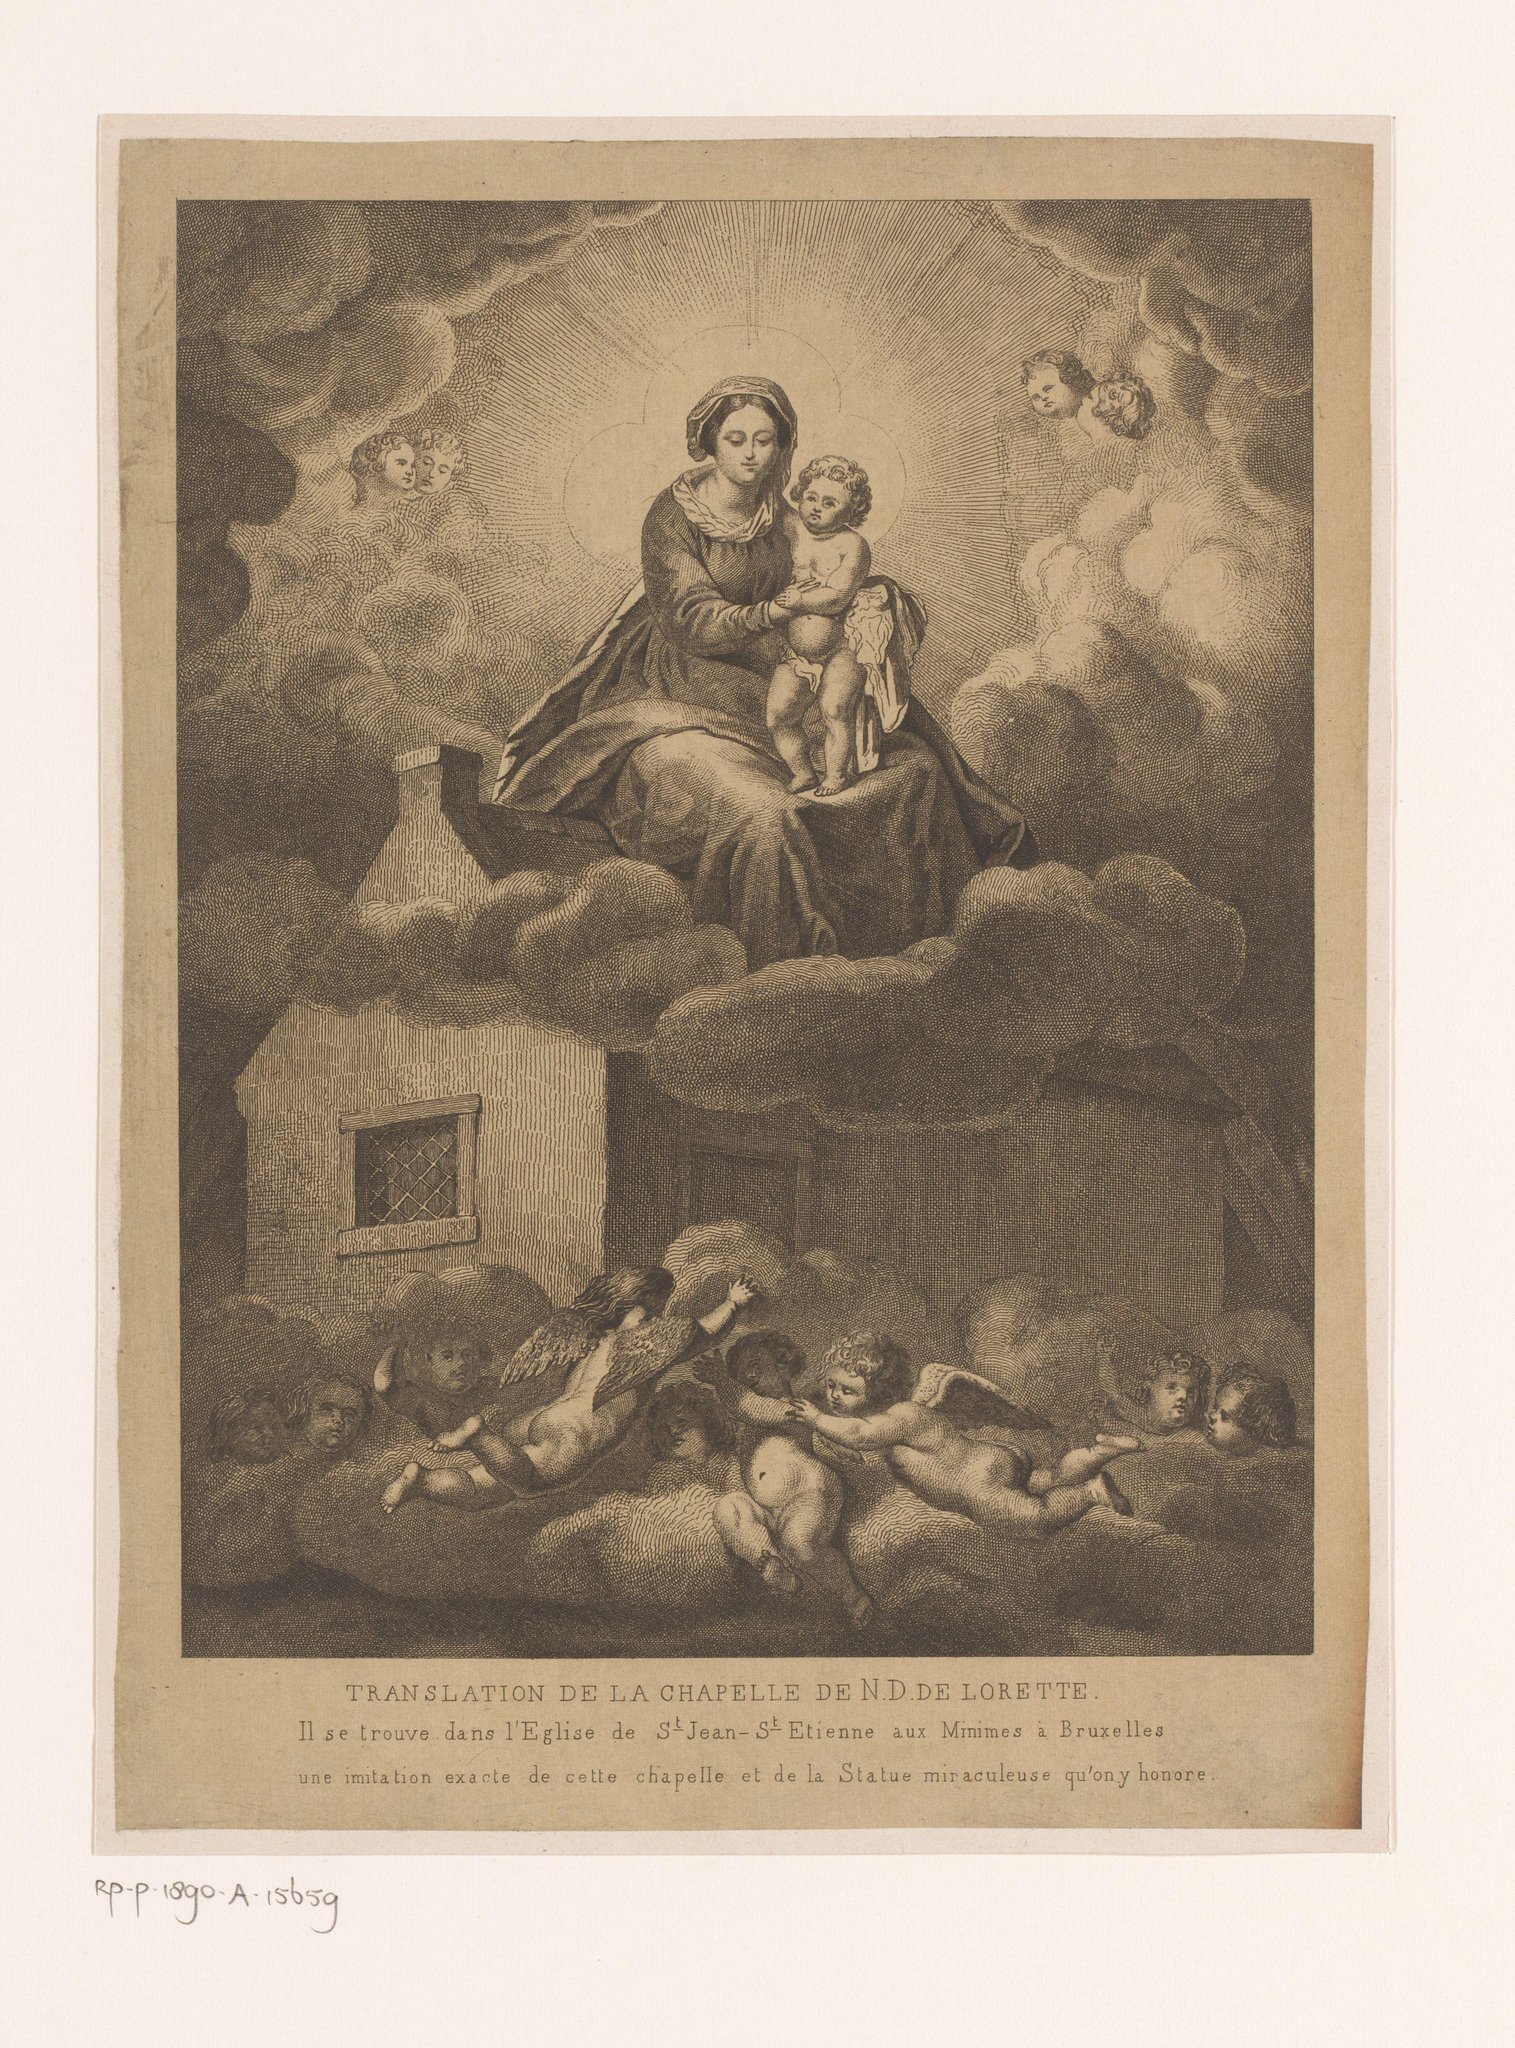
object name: print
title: Translation de la chapelle de N.D. de Lorette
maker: jean théodore joseph linnig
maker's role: draughtsman, print maker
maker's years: 1815-1891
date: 1825-1890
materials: paper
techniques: engraving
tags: mary sitting or enthroned, the christ-child standing on her knee (christ-child to mary's left), the house of nazareth which came to loreto (mary-miracle)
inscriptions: collector's mark: Lugt 2228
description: Reproductie van de bovenste helft van de anonieme 17e-eeuwse ets met titel "Het broederschap van onse L: Vrouwe van Loretten opgherecht [...]".